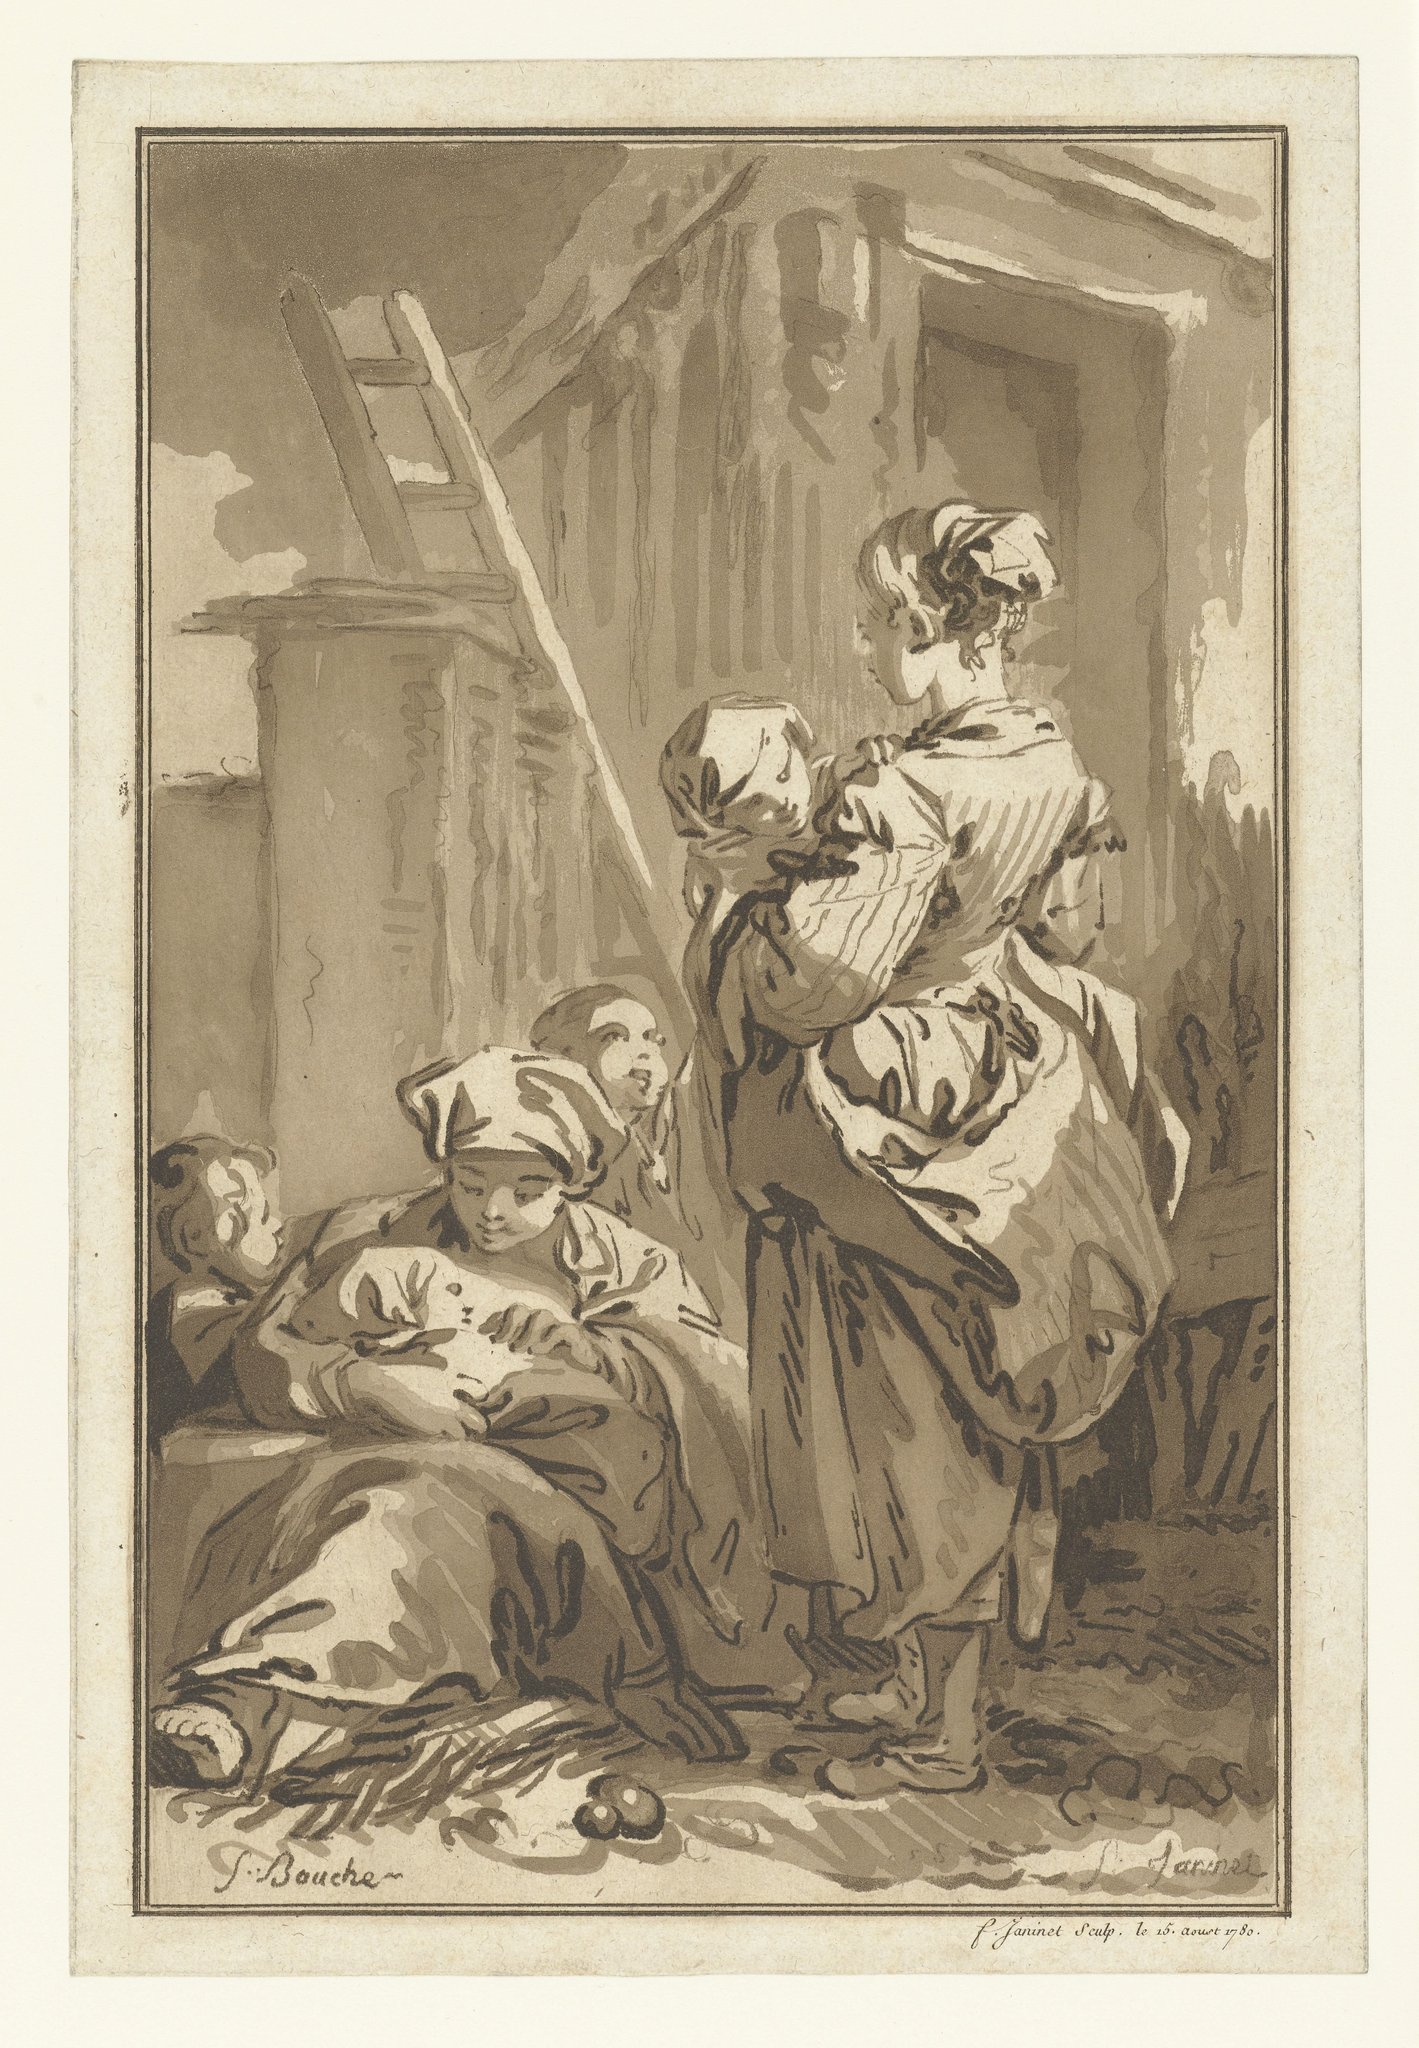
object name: print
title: Les Nourrices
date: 1780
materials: paper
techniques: aquatint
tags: wet-nurse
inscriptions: collector's mark: Lugt 270, collector's mark: ‘JC ?’, collector's mark: Lugt 2228